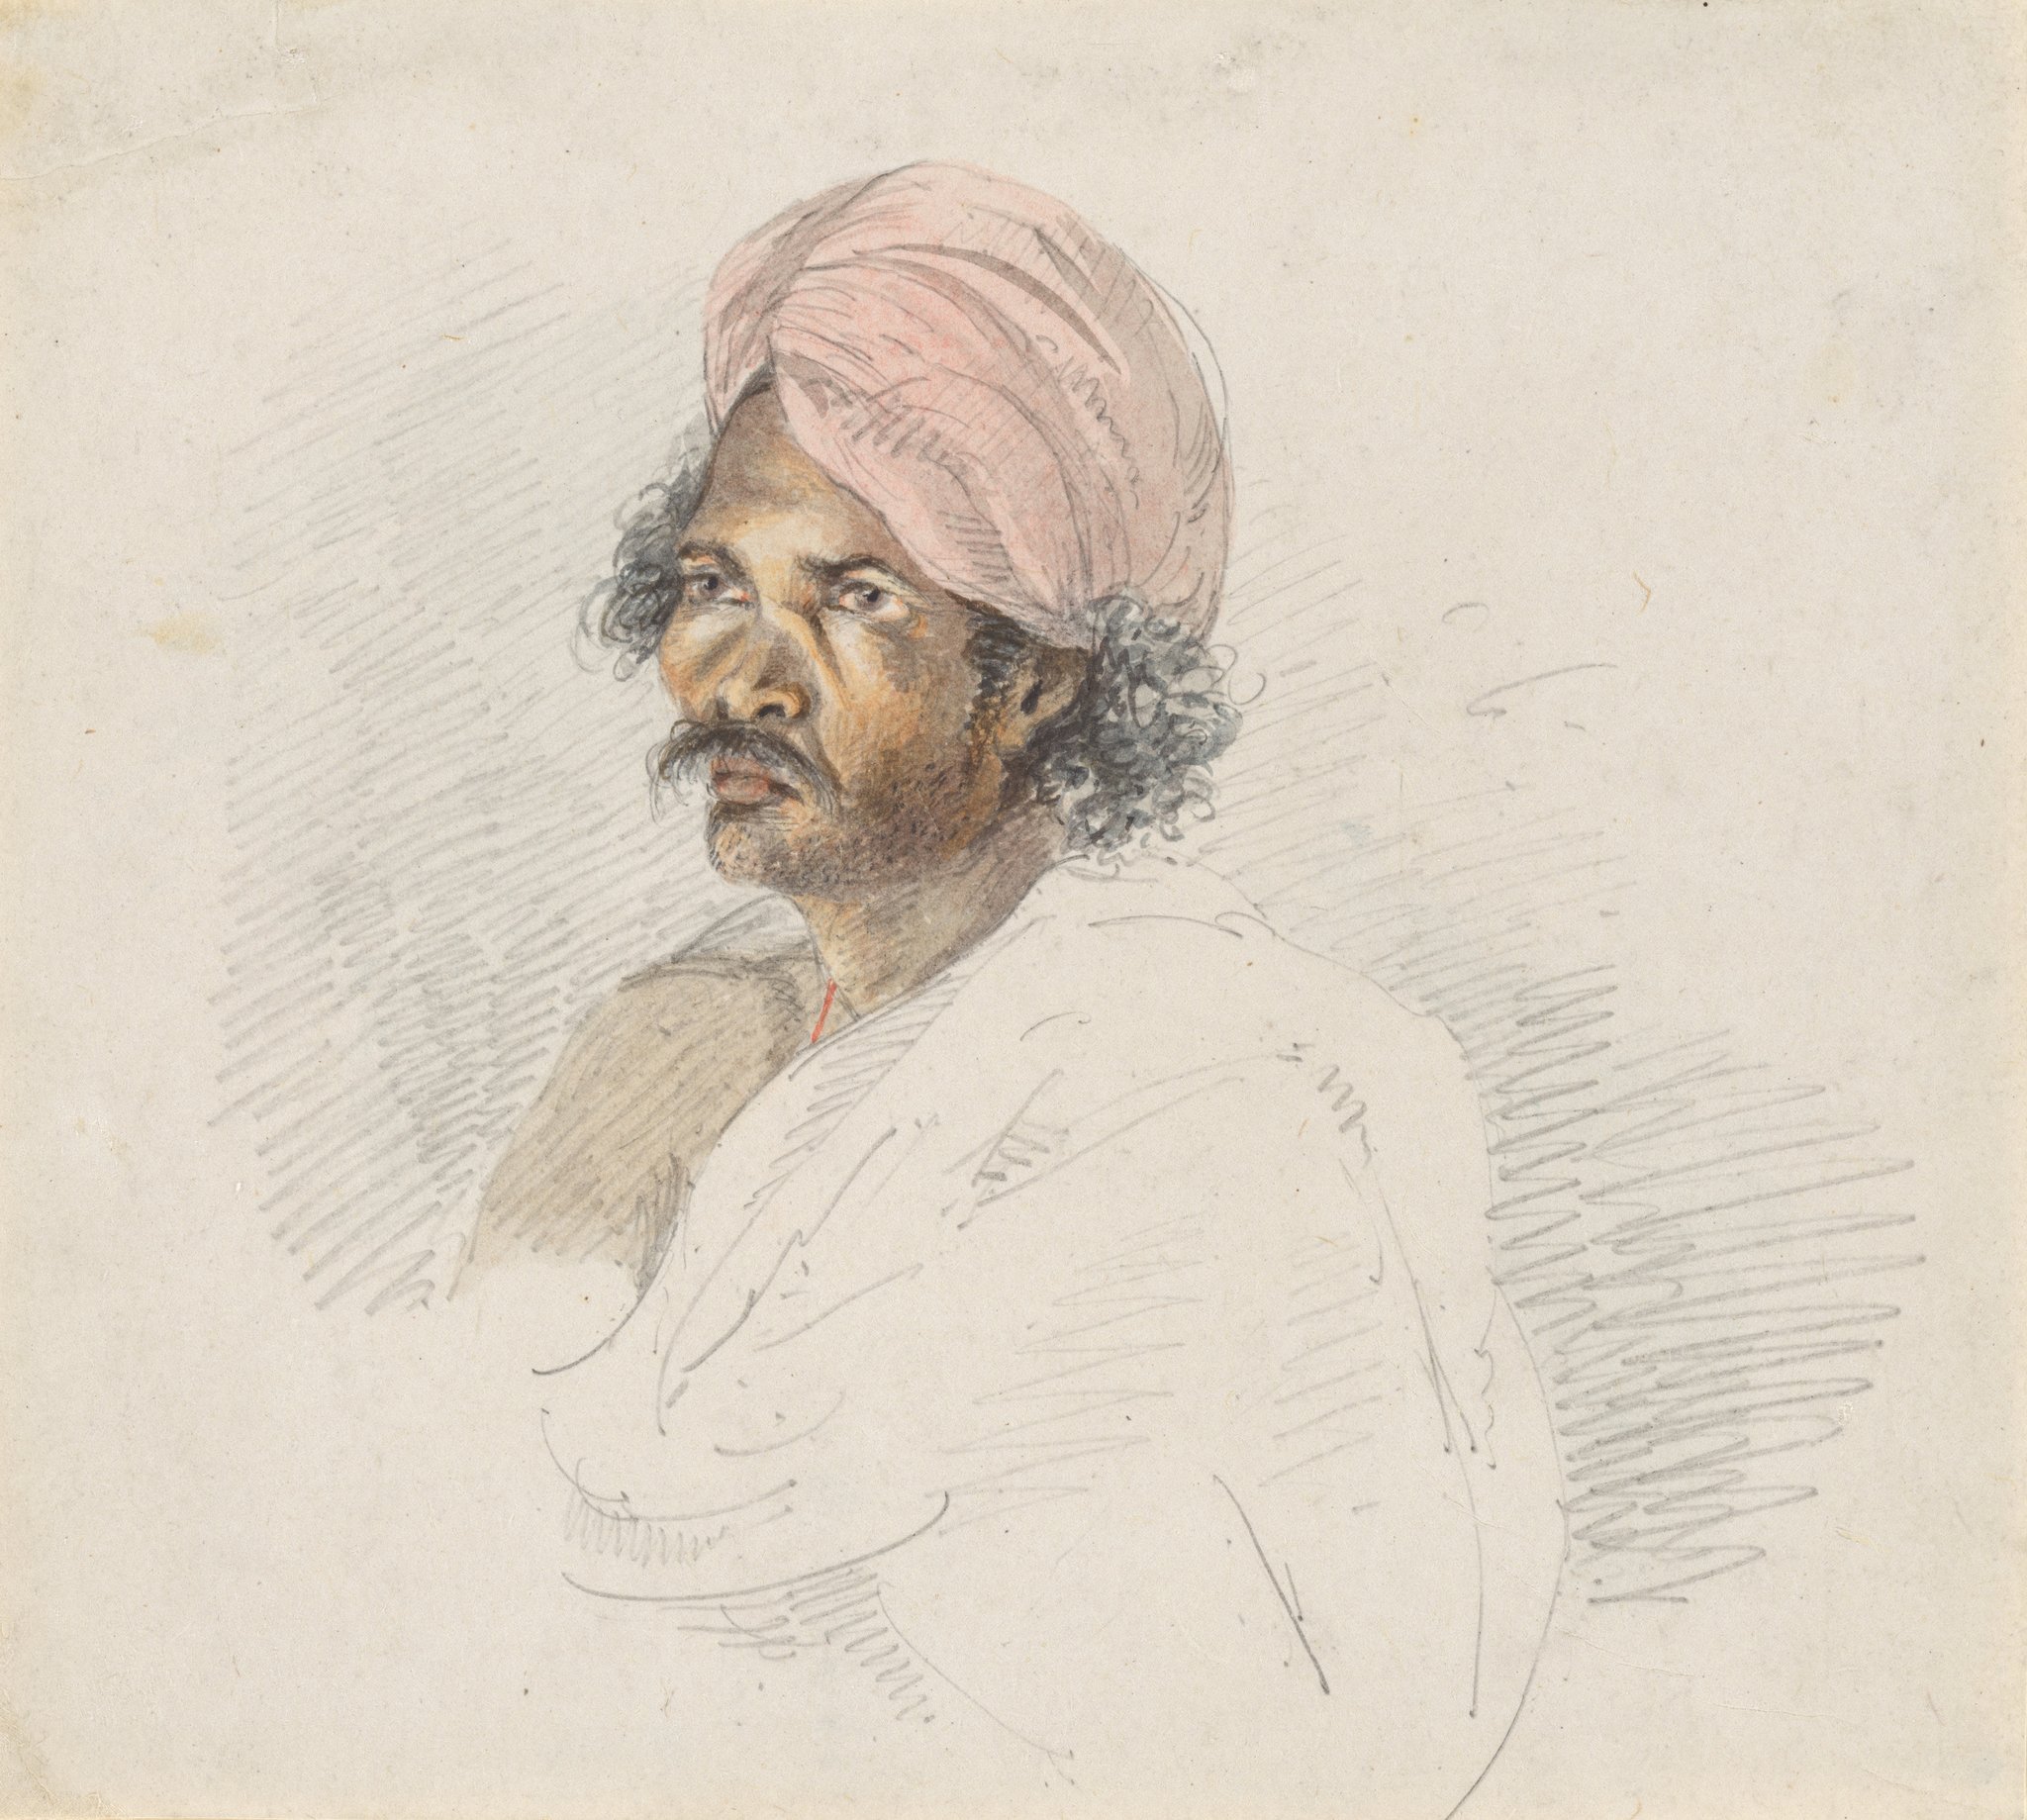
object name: portrait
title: Portrait of a Sri Lankan Tamil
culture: sri lankan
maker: samuel daniell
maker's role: artist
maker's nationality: british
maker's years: 1775-1811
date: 1806-1807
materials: graphite, paper, watercolor